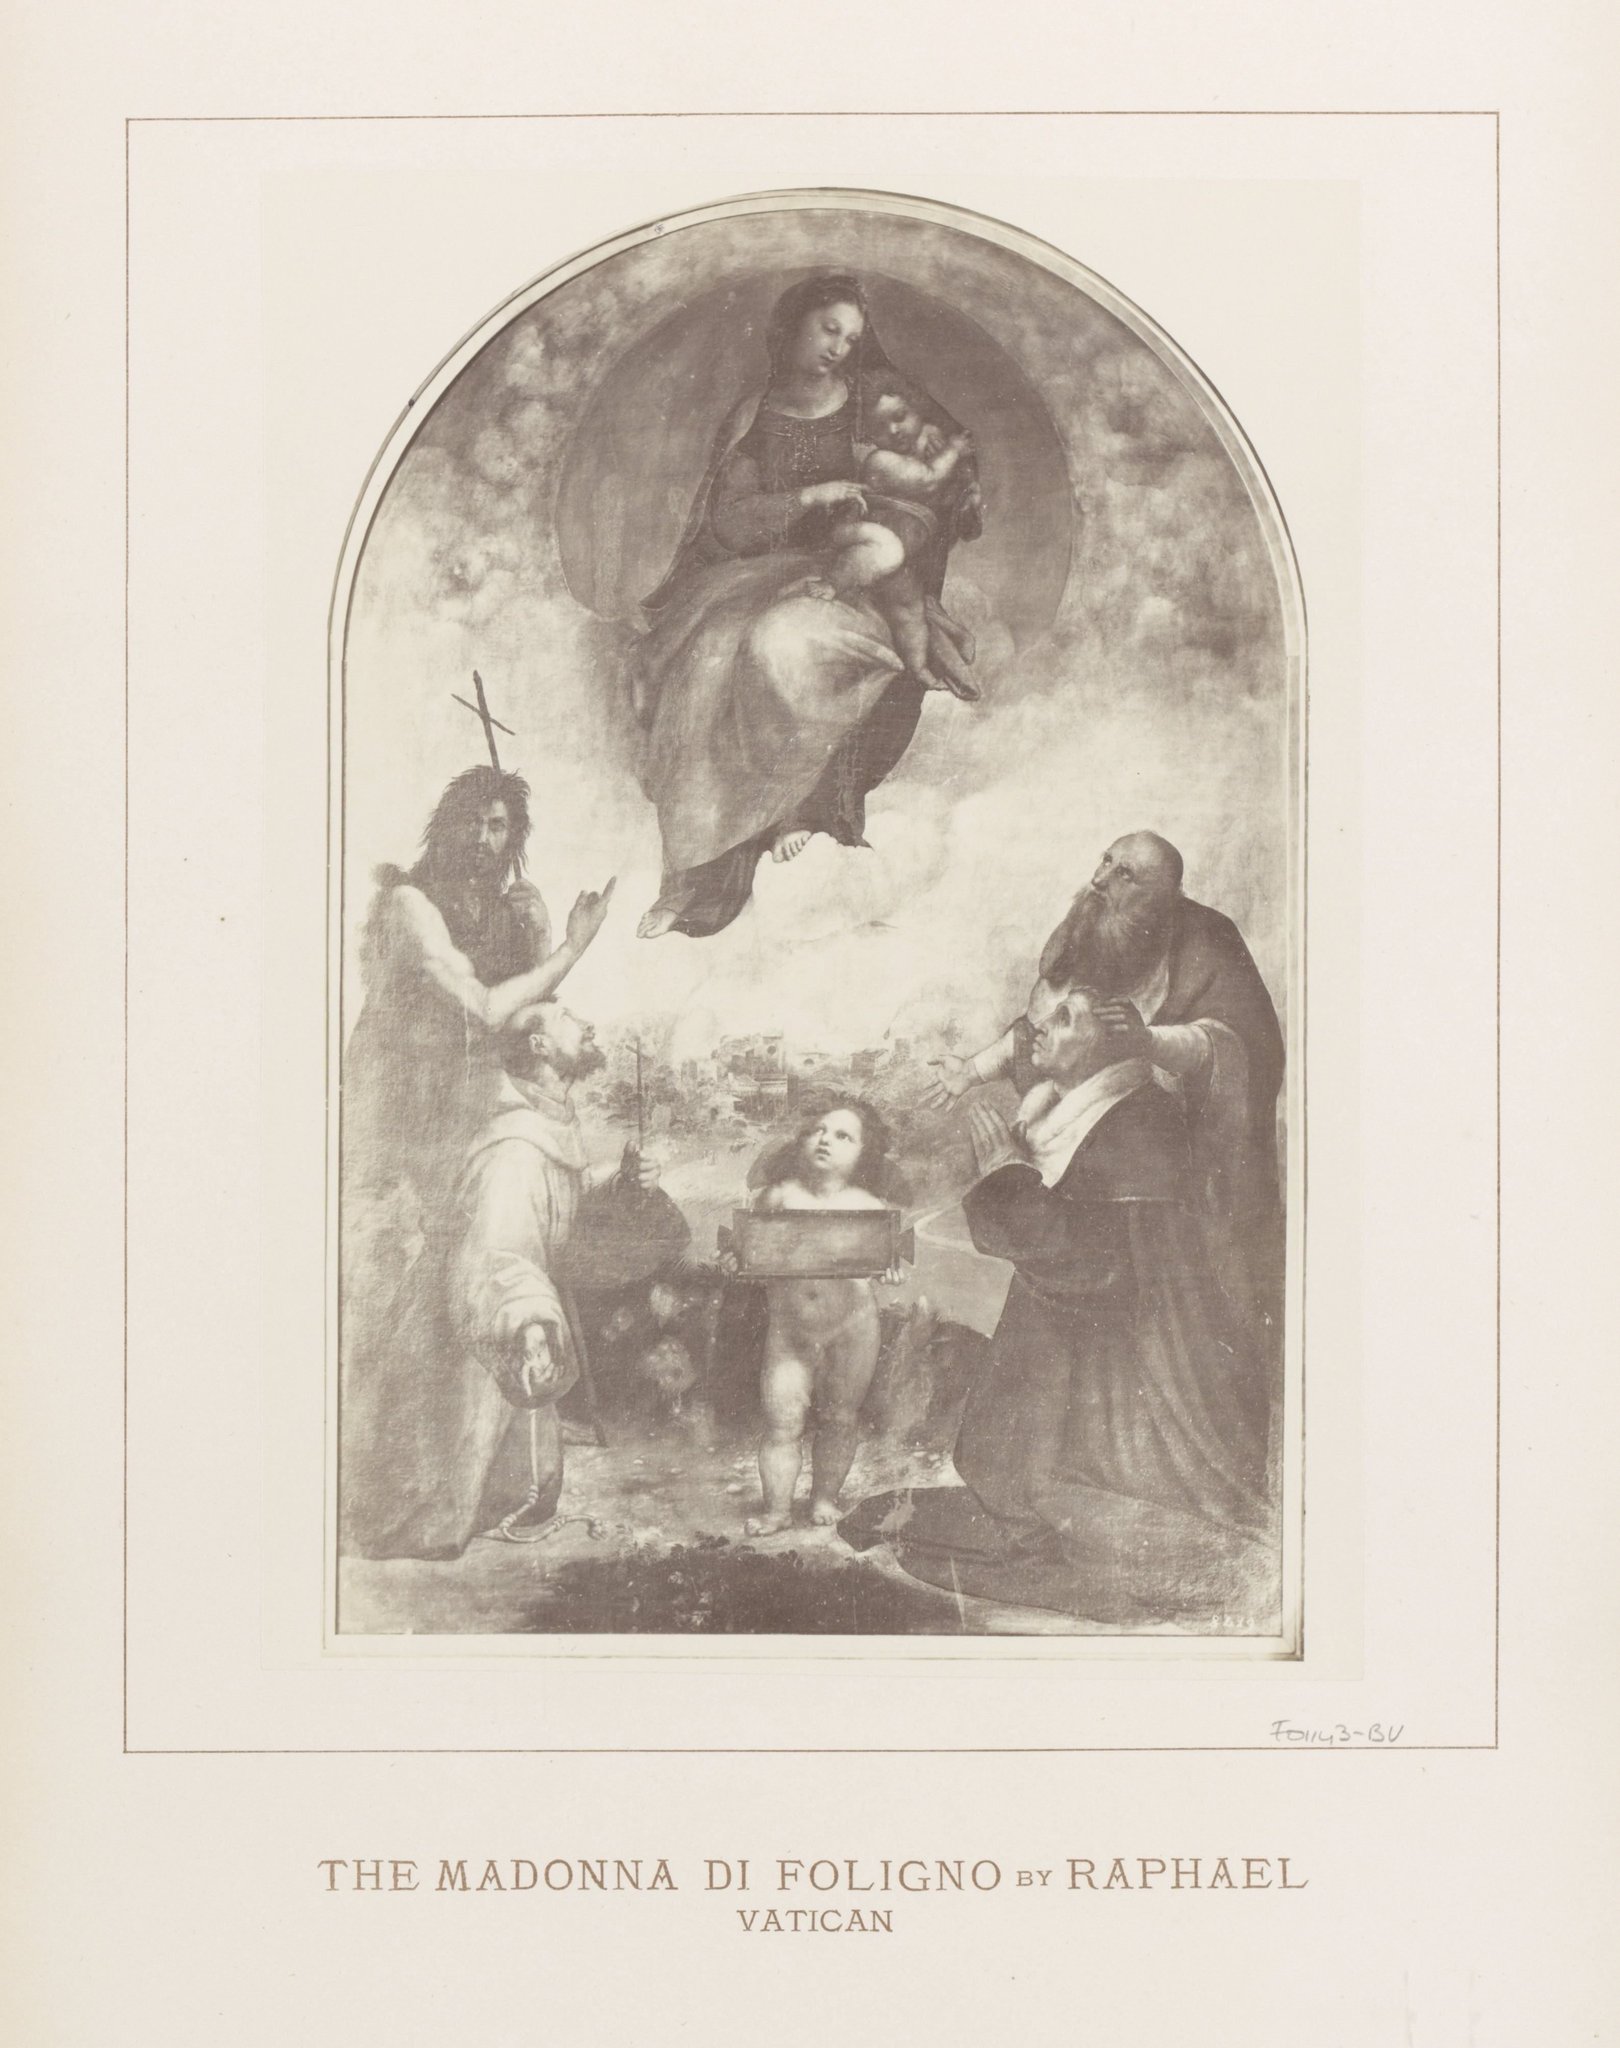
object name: reproduction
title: The Madonna di Foligno by Raphael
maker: Anonymous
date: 1860-1900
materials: photographic support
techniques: albumen print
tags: madonna: i.e. mary with the christ-child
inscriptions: number: ‘8419’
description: Onderdeel van Fotoalbum met opnames van bezienswaardigheden en kunstwerken in Rome.